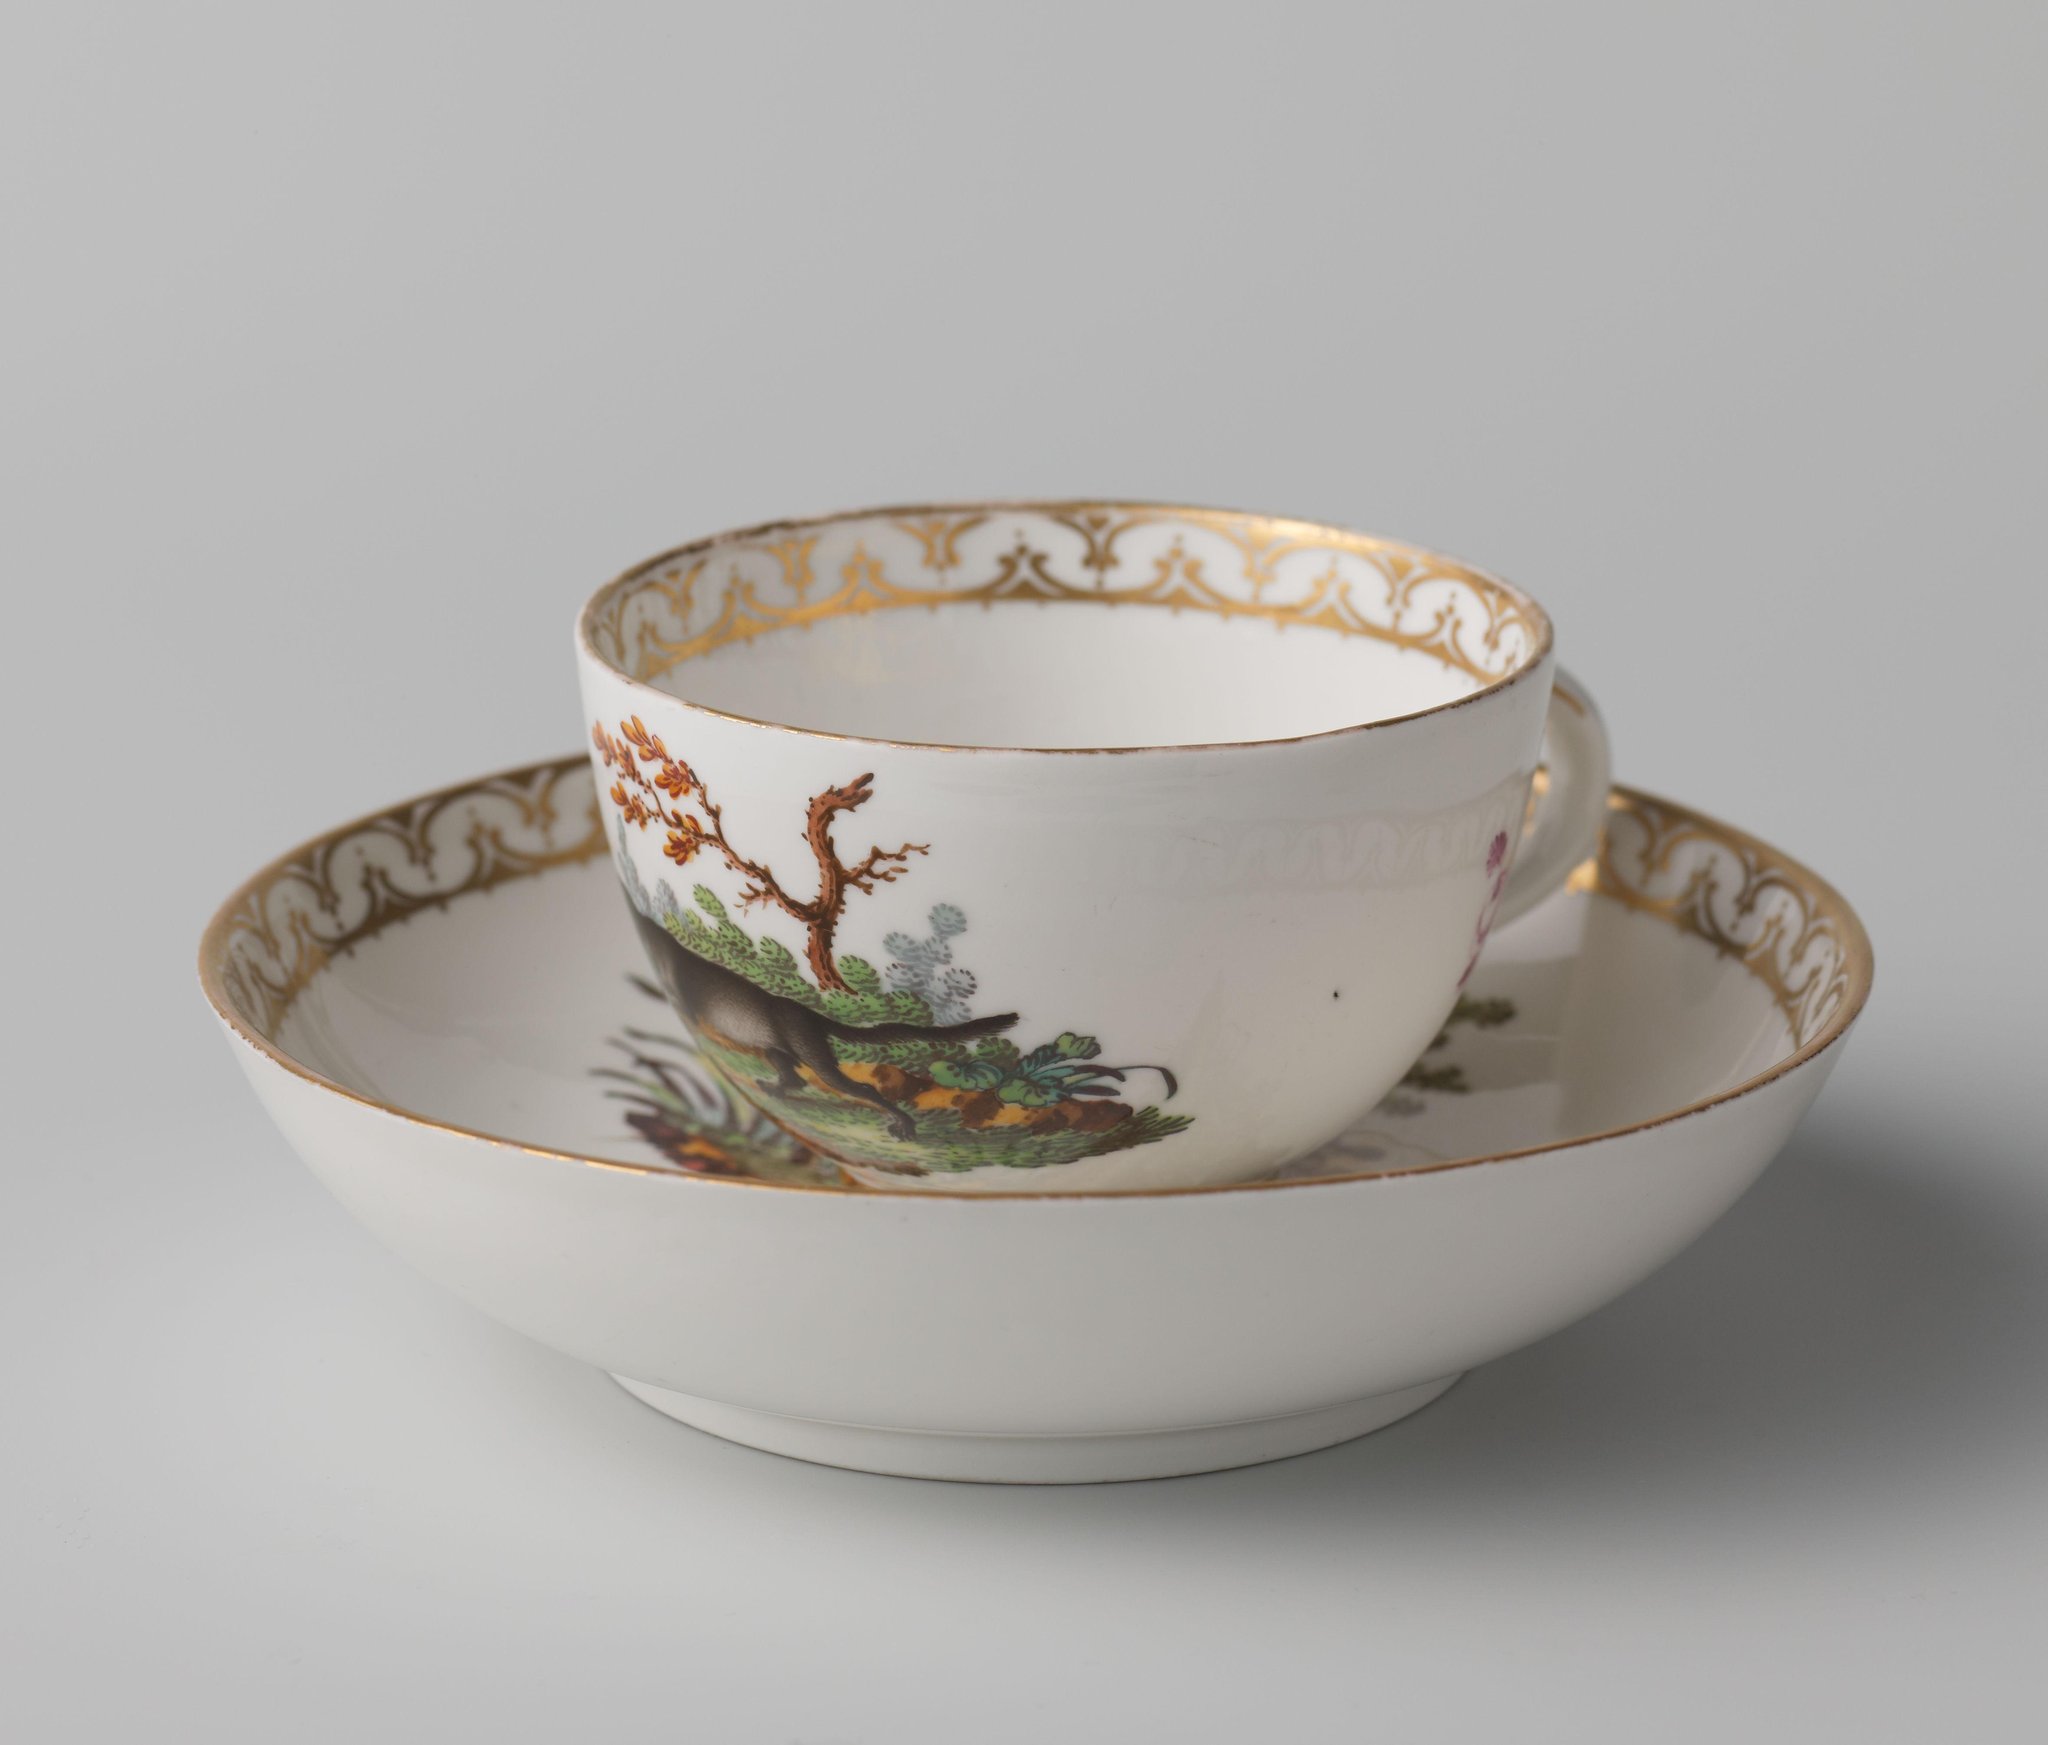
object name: kop en schotel, kop en schotel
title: Kop veelkleurig versierd met een hond op een grondje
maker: Anonymous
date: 1777-1790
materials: porcelain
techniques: painted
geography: ansbach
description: Kop veelkleurig versierd met een hond op een grondje. Langs de randen een rij dubbele boogjes. N.B. Duits porselein beschilderd in Den Haag. Gemerkt met blauwe ooievaar.